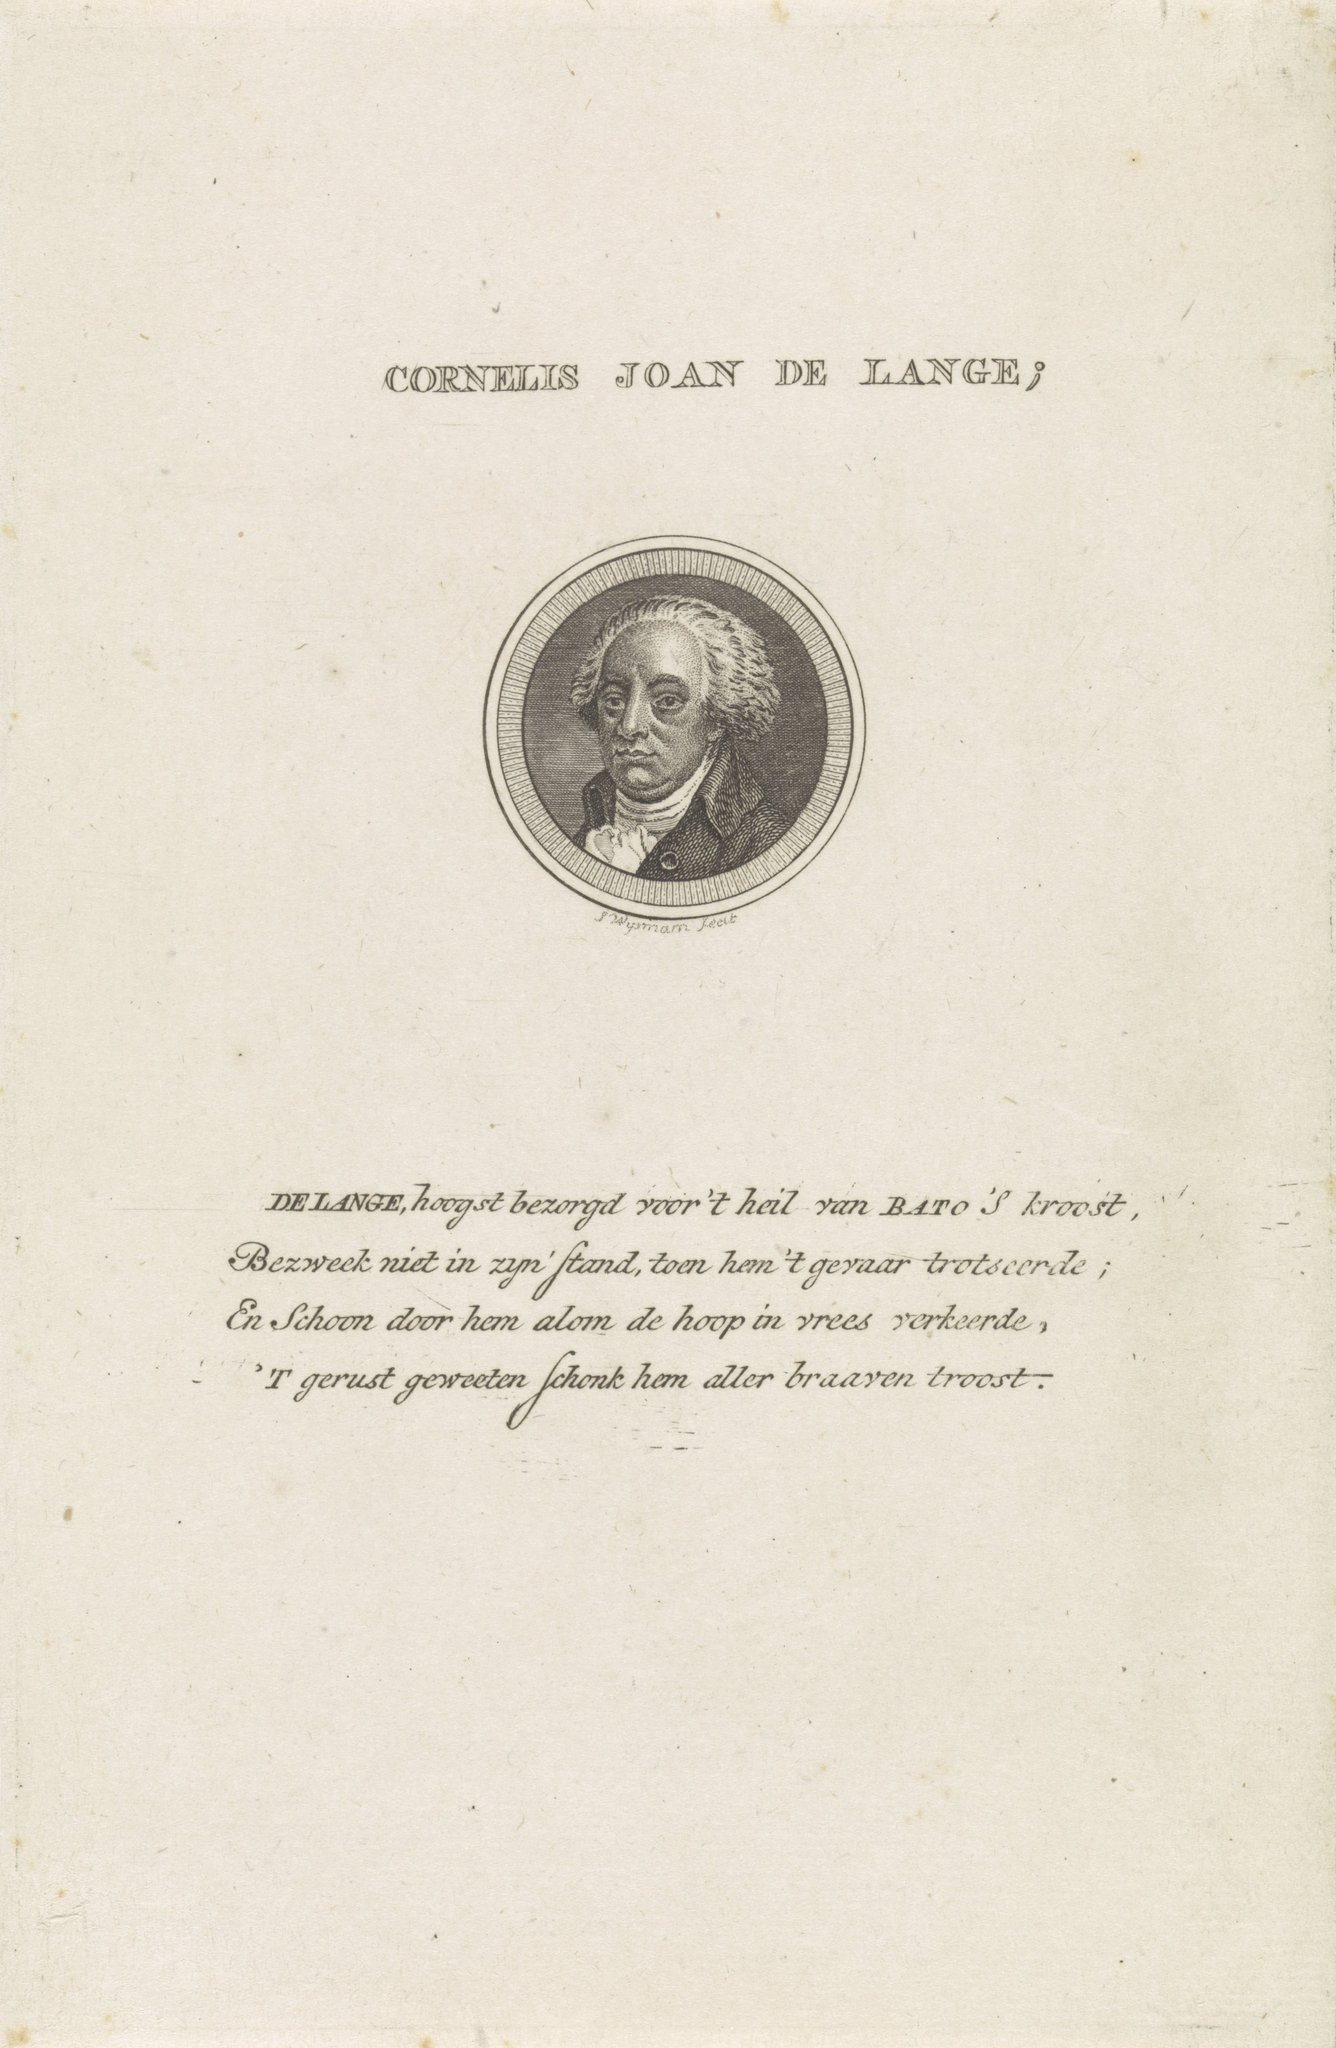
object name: print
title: Portretten van patriotten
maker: jacobus wijsman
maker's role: print maker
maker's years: 1768-1827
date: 1795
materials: paper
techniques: engraving, etching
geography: amsterdam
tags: schepen, cornelis johan de lange van wijngaarden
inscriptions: collector's mark: Lugt 2228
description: Prent maakt deel uit van een serie, die in drie afleveringen werd uitgegeven onder de titel: Verzameling van Afbeeldingen van Nederlandsche Mannen, beroemd geworden, wegens hunne Moed en Burgerliefde in de jongstledene Beroerten. 1794-1795. Zie Atlas van Stolk.